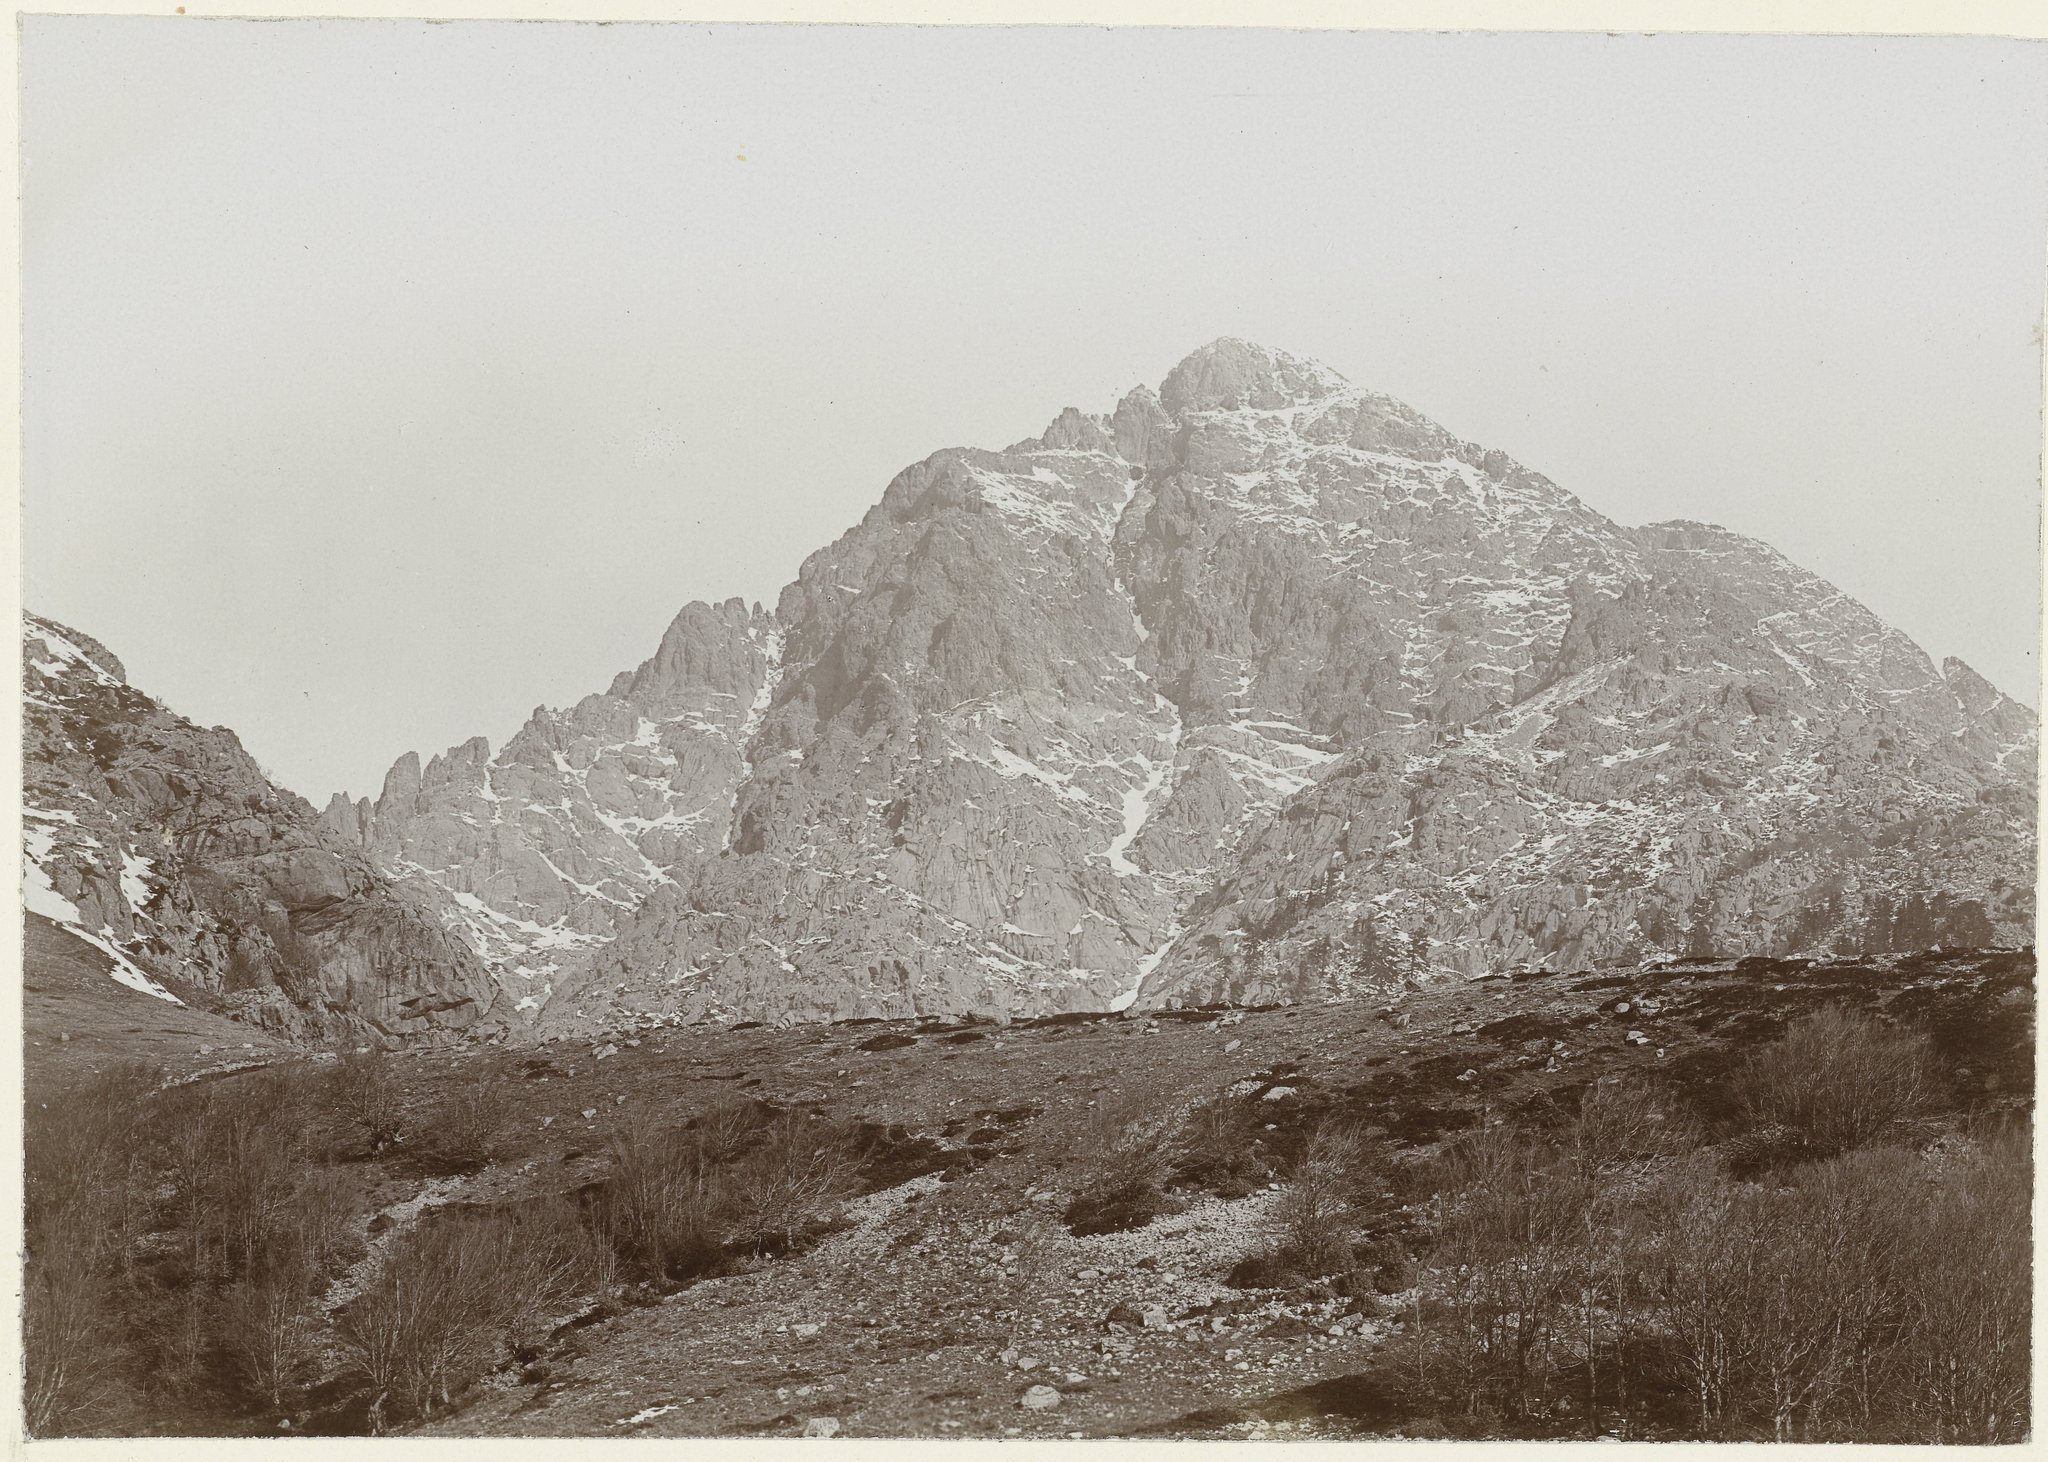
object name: photograph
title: Monte d'Oro op Corsica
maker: henry pauw van wieldrecht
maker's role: fotograaf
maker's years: 1863-1912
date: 1886-1896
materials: cardboard, photographic support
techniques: albumen print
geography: corsica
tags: corsica